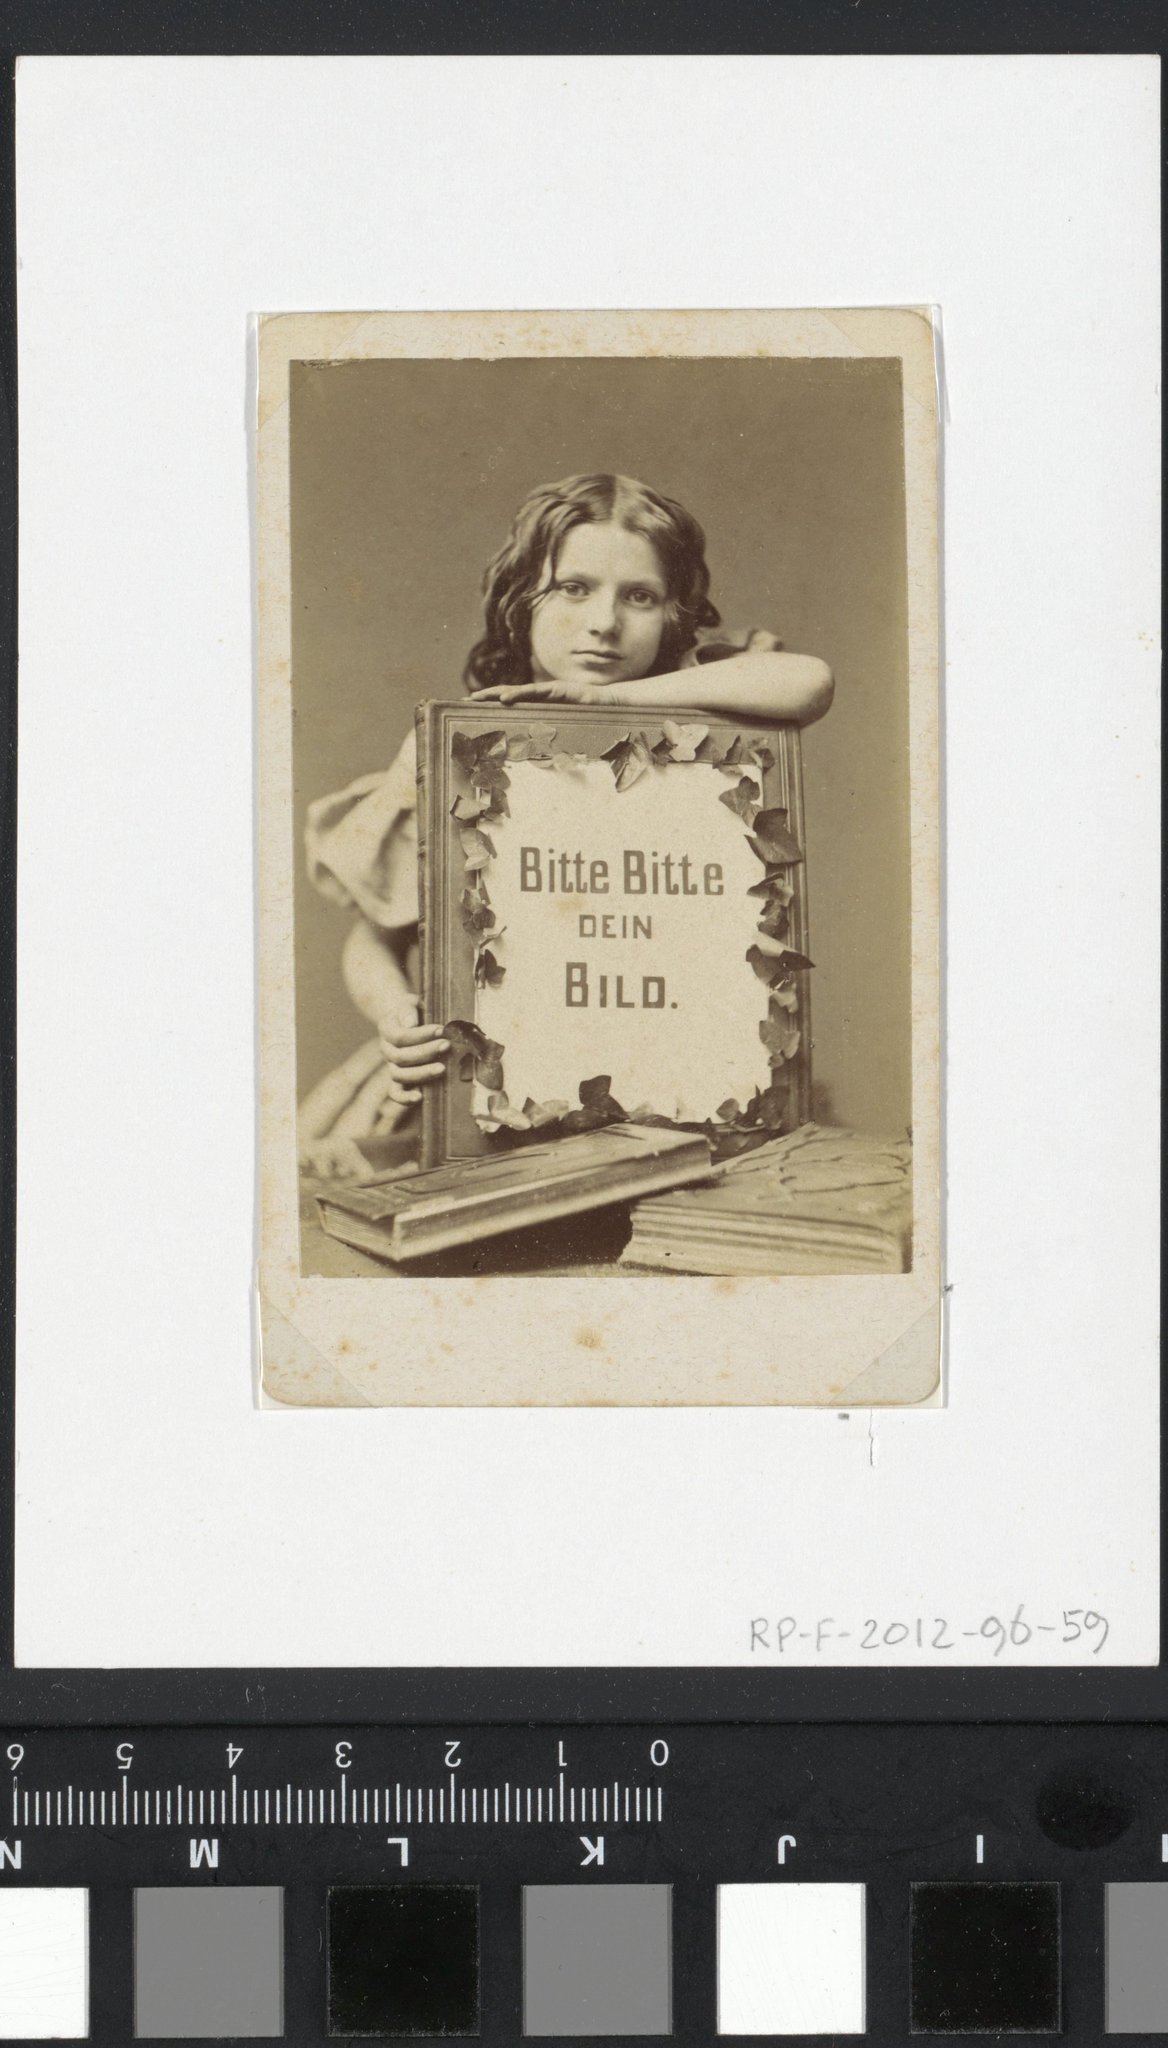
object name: carte de visite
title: Portret van een meisje met een boek met de tekst 'Bitte Bitte dein Bild'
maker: Anonymous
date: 1870-1890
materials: cardboard, paper, photographic support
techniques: albumen print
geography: europe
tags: historical persons not known by name - bb - woman, child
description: Met dit soort kaarten werden mensen, aan wie een cartes-de-visite-album ter inzage werd gegeven, aangespoord om ook hun carte-de-visite aan de albumeigenaar af te staan.